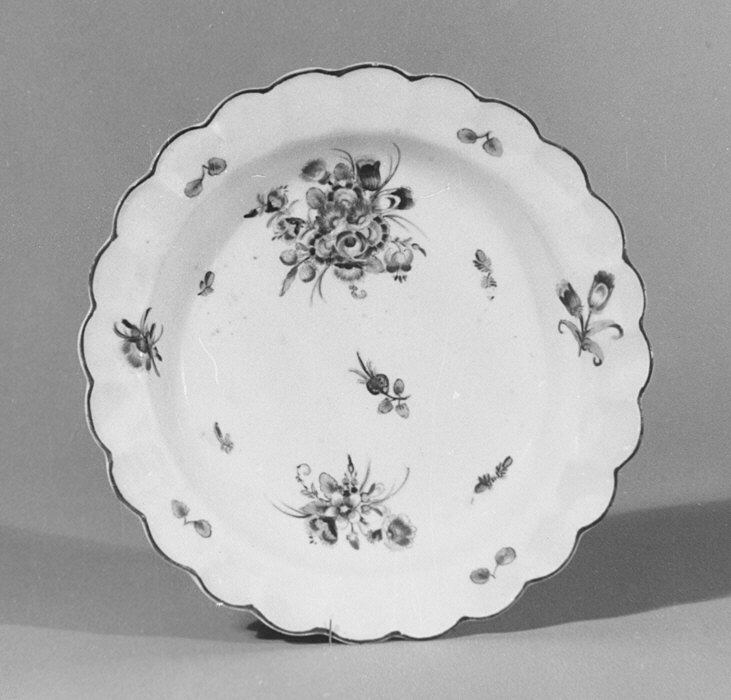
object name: plate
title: Small plate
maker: worcester factory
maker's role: factory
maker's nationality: british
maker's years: 1751-2008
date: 1760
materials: soft paste porcelain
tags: flowers